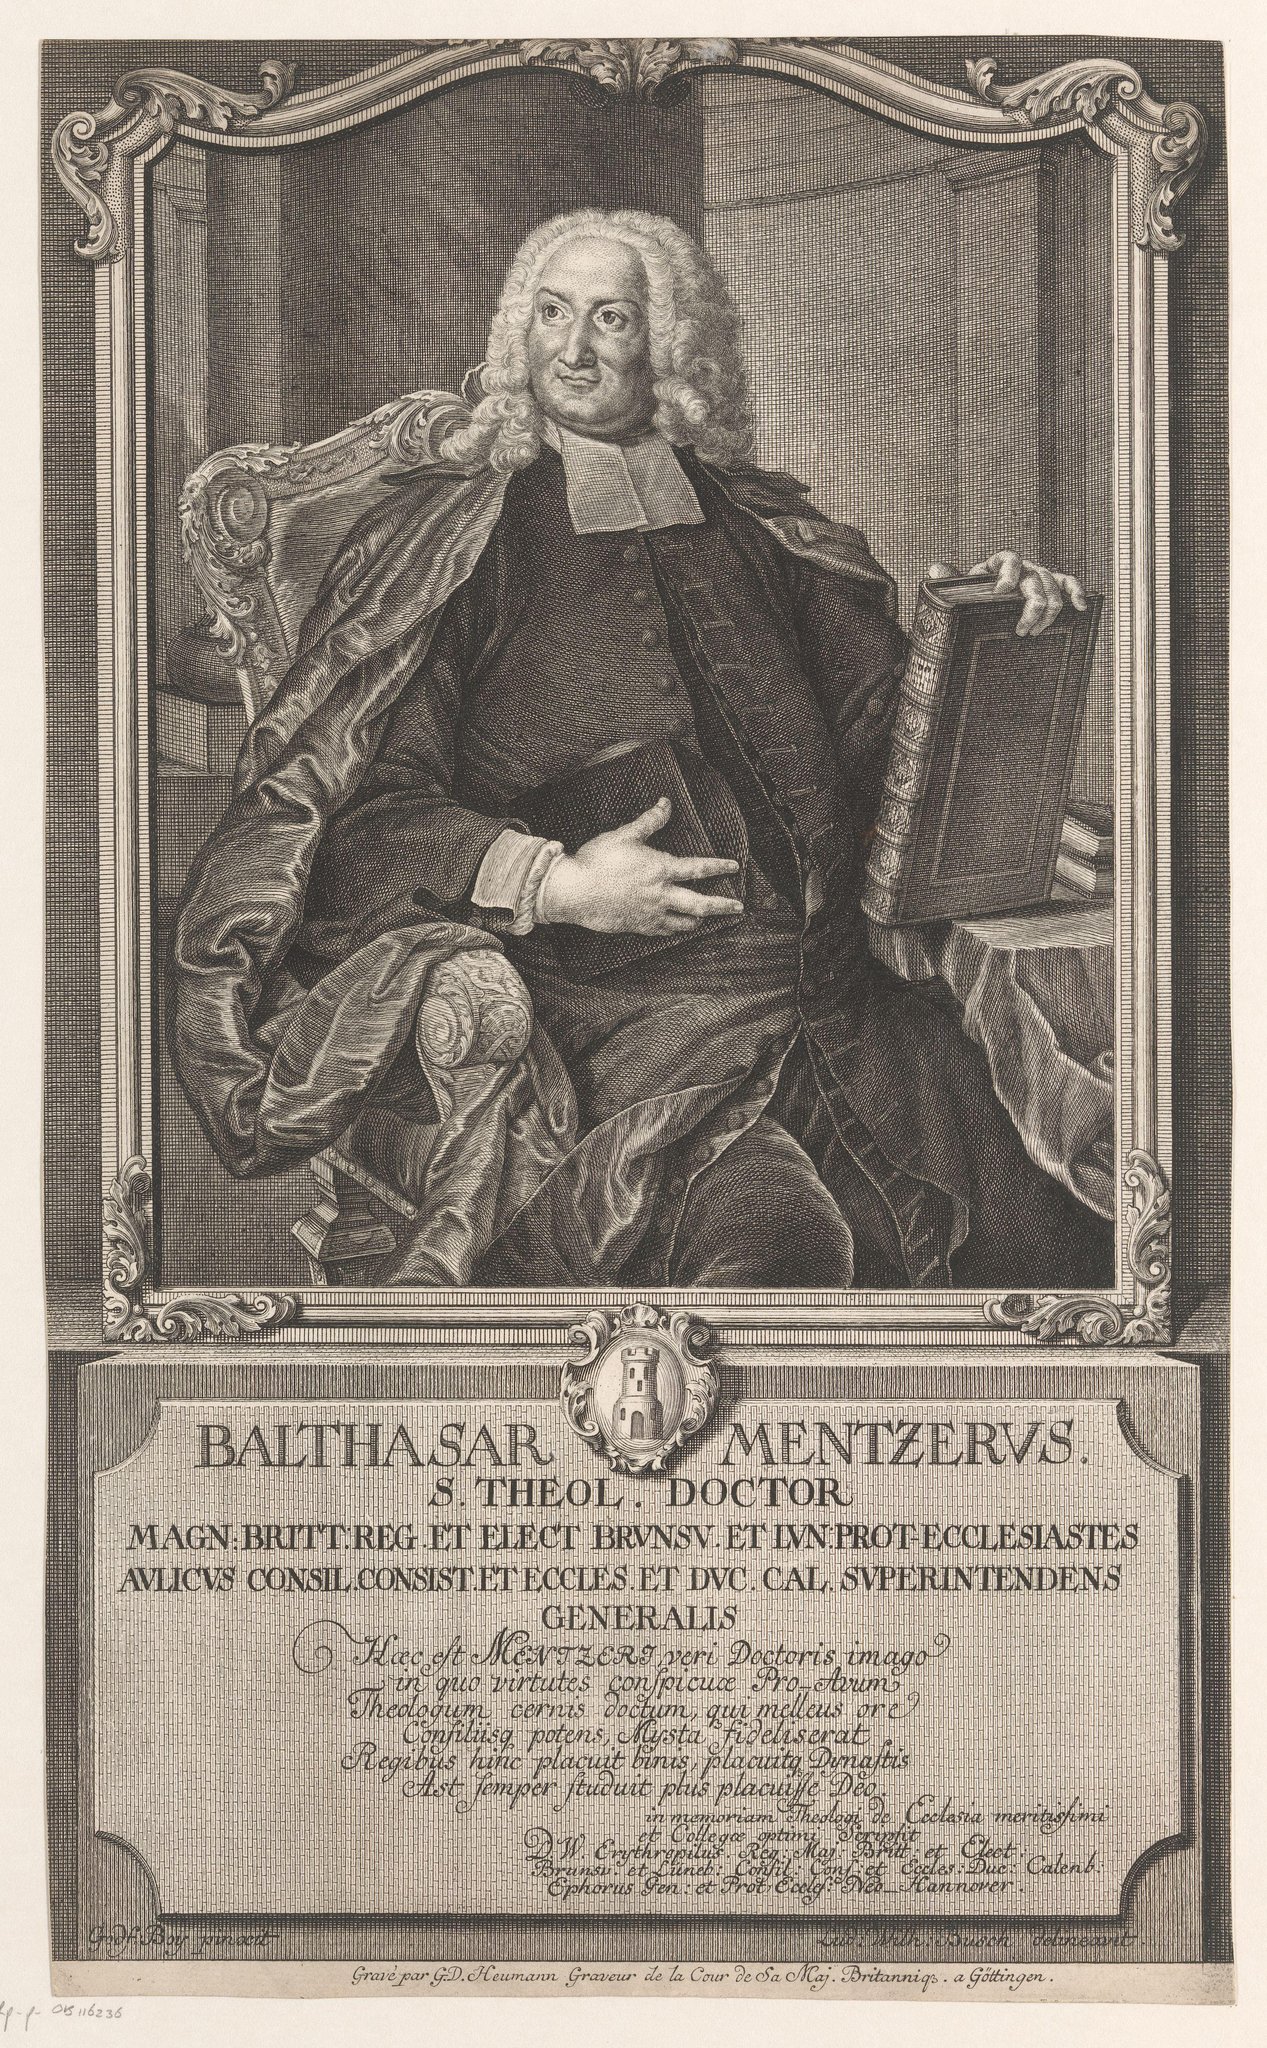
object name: print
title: Portret van Balthasar Mentzer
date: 1713-1759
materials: paper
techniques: engraving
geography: gottingen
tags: balthasar mentzer, historical persons, armorial bearing, heraldry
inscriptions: collector's mark: Lugt 2228